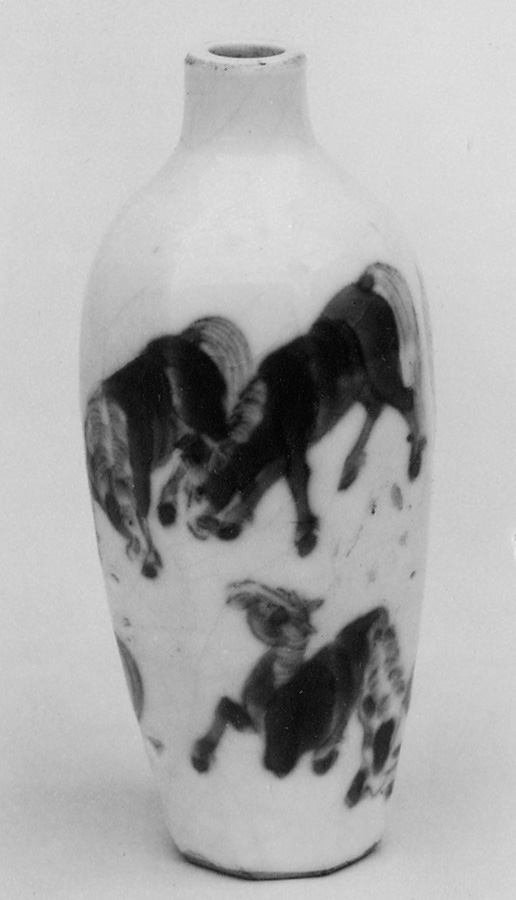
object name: snuff bottle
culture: chinese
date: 1701-1800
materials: porcelain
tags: horses